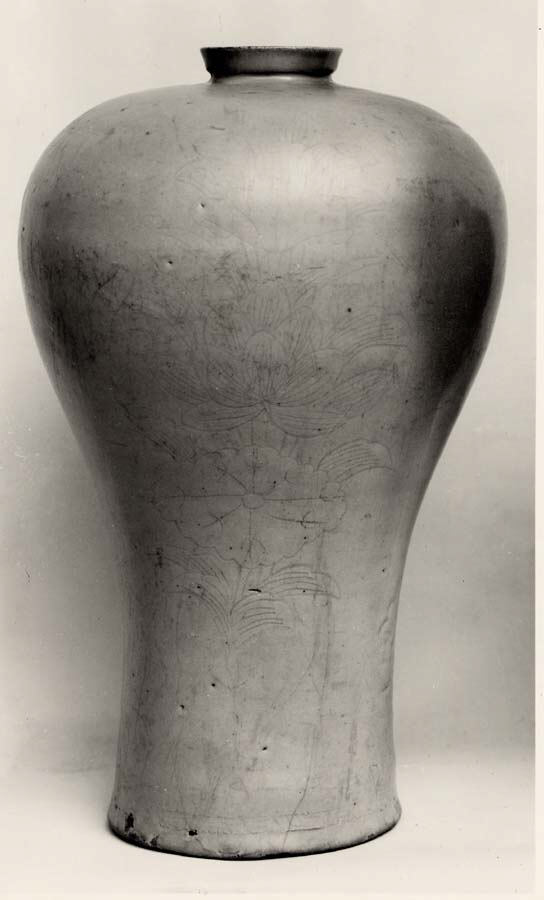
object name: vase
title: Maebyeong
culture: korean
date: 1201-1300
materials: stoneware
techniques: incising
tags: flowers